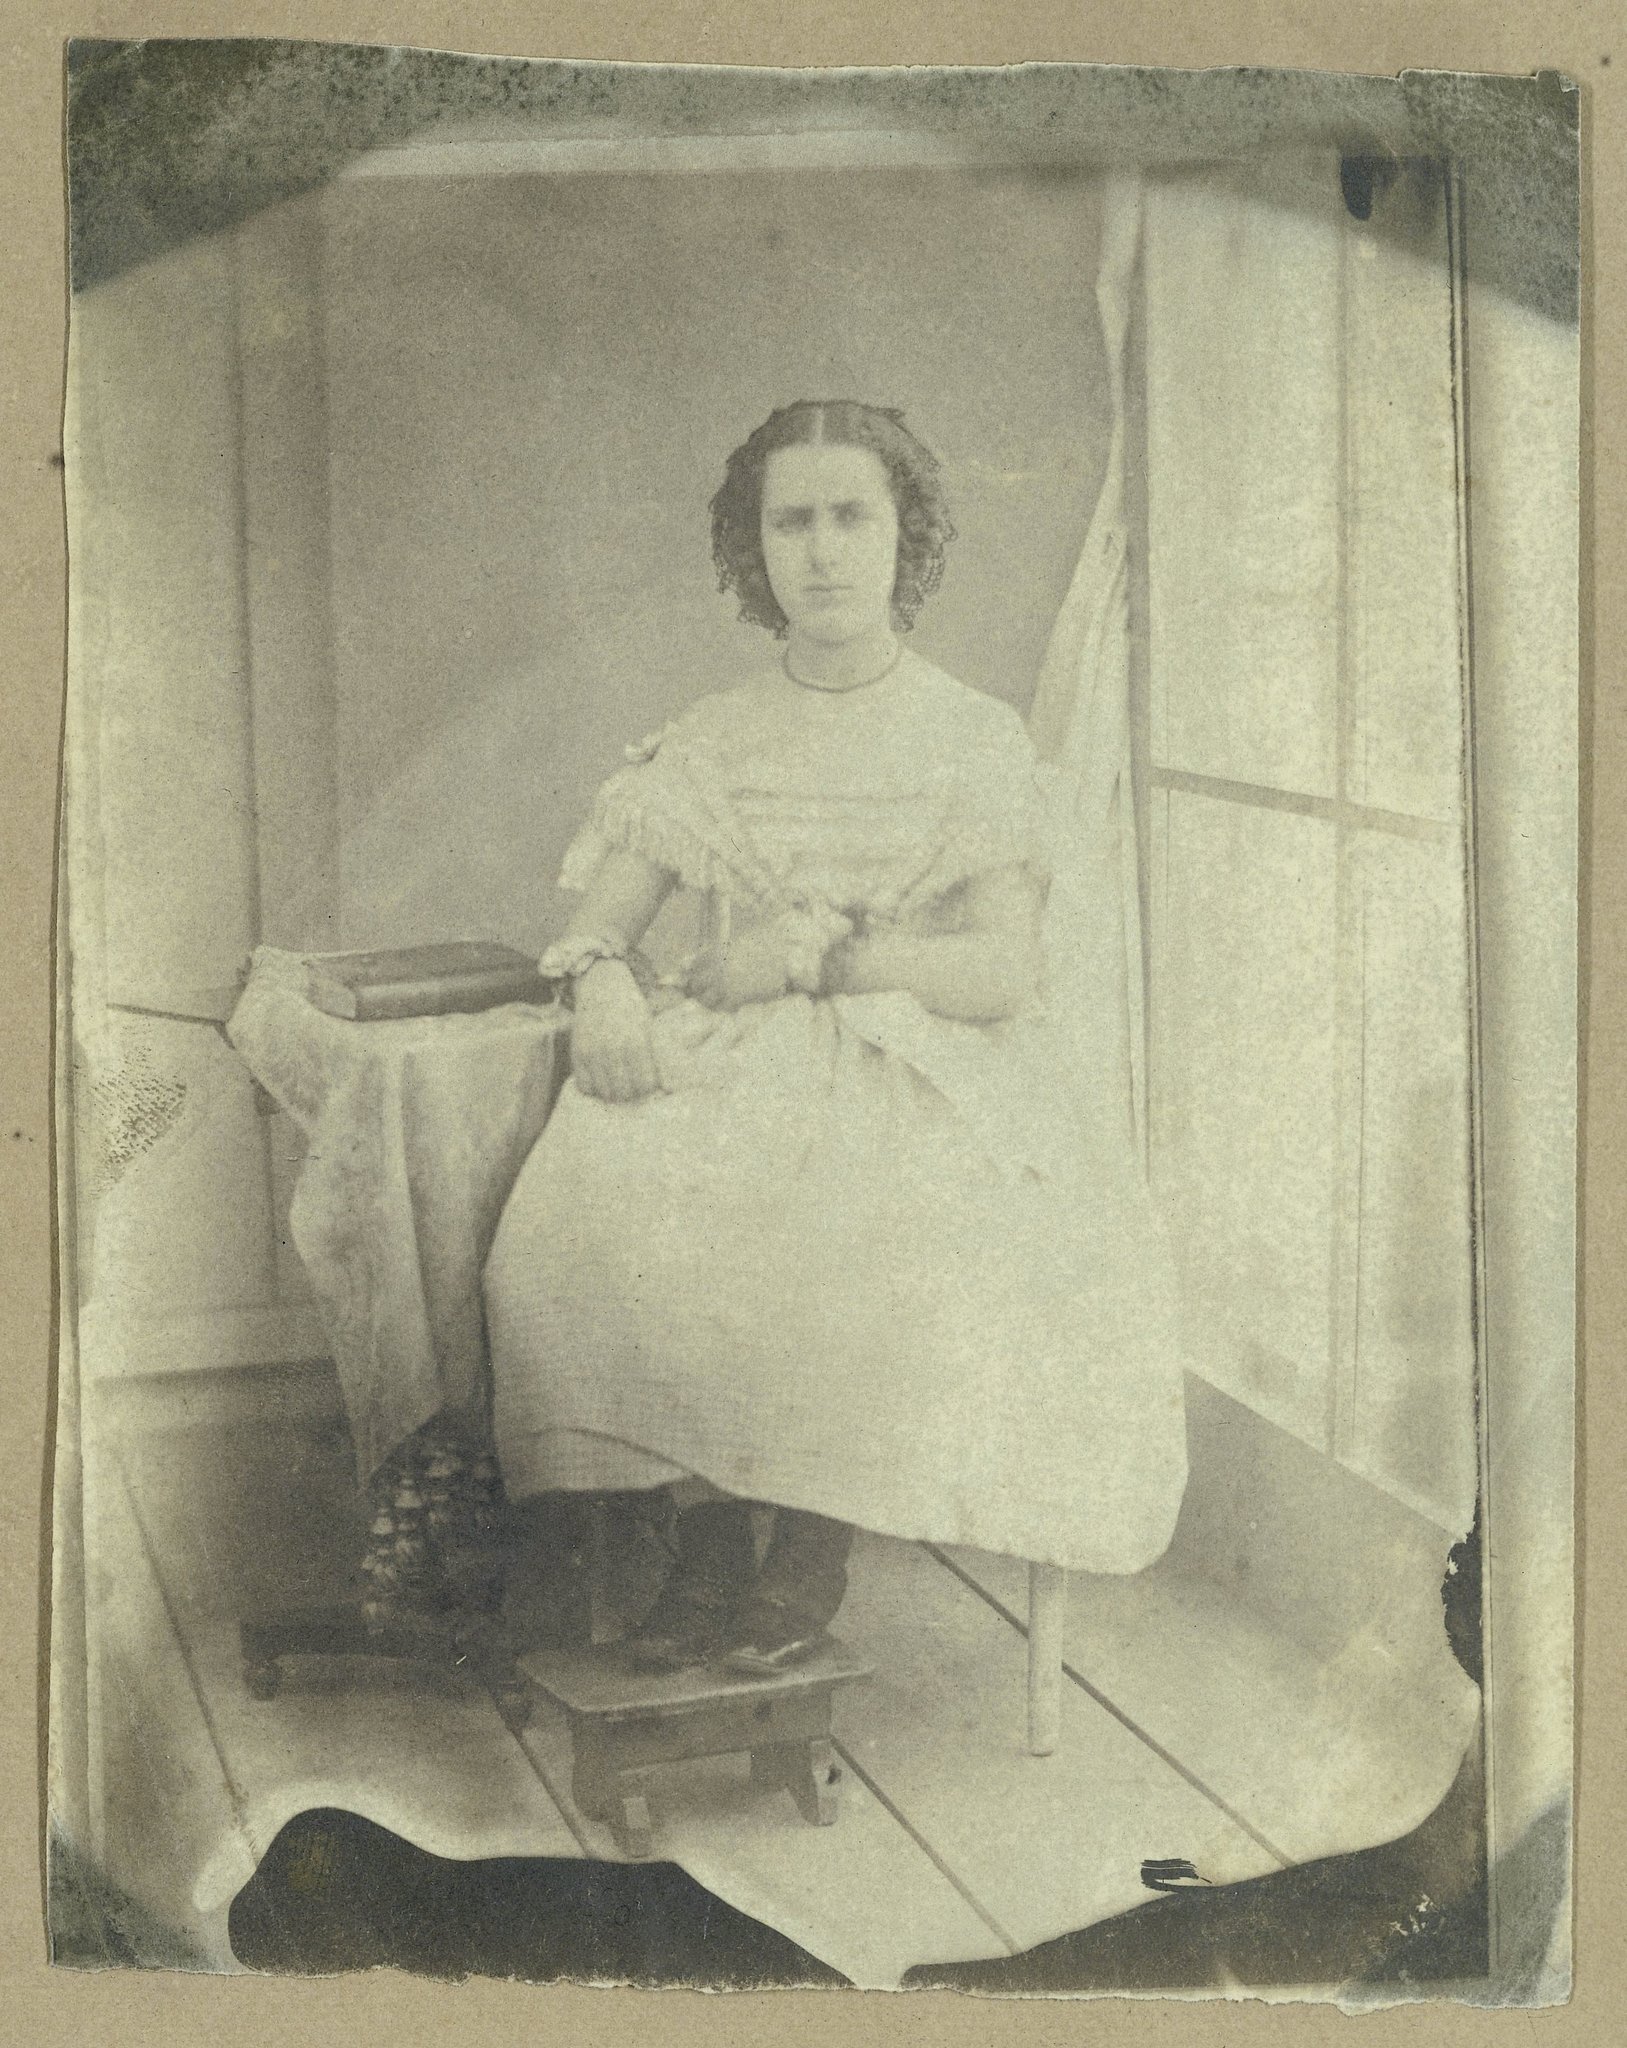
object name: photograph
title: Portret van Anna-Gratia Asser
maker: eduard isaac asser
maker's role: amateurfotograaf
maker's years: 1809-1894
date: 1854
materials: cardboard, paper, photographic support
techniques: salted paper print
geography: amsterdam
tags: historical persons - bb - woman, netherlands